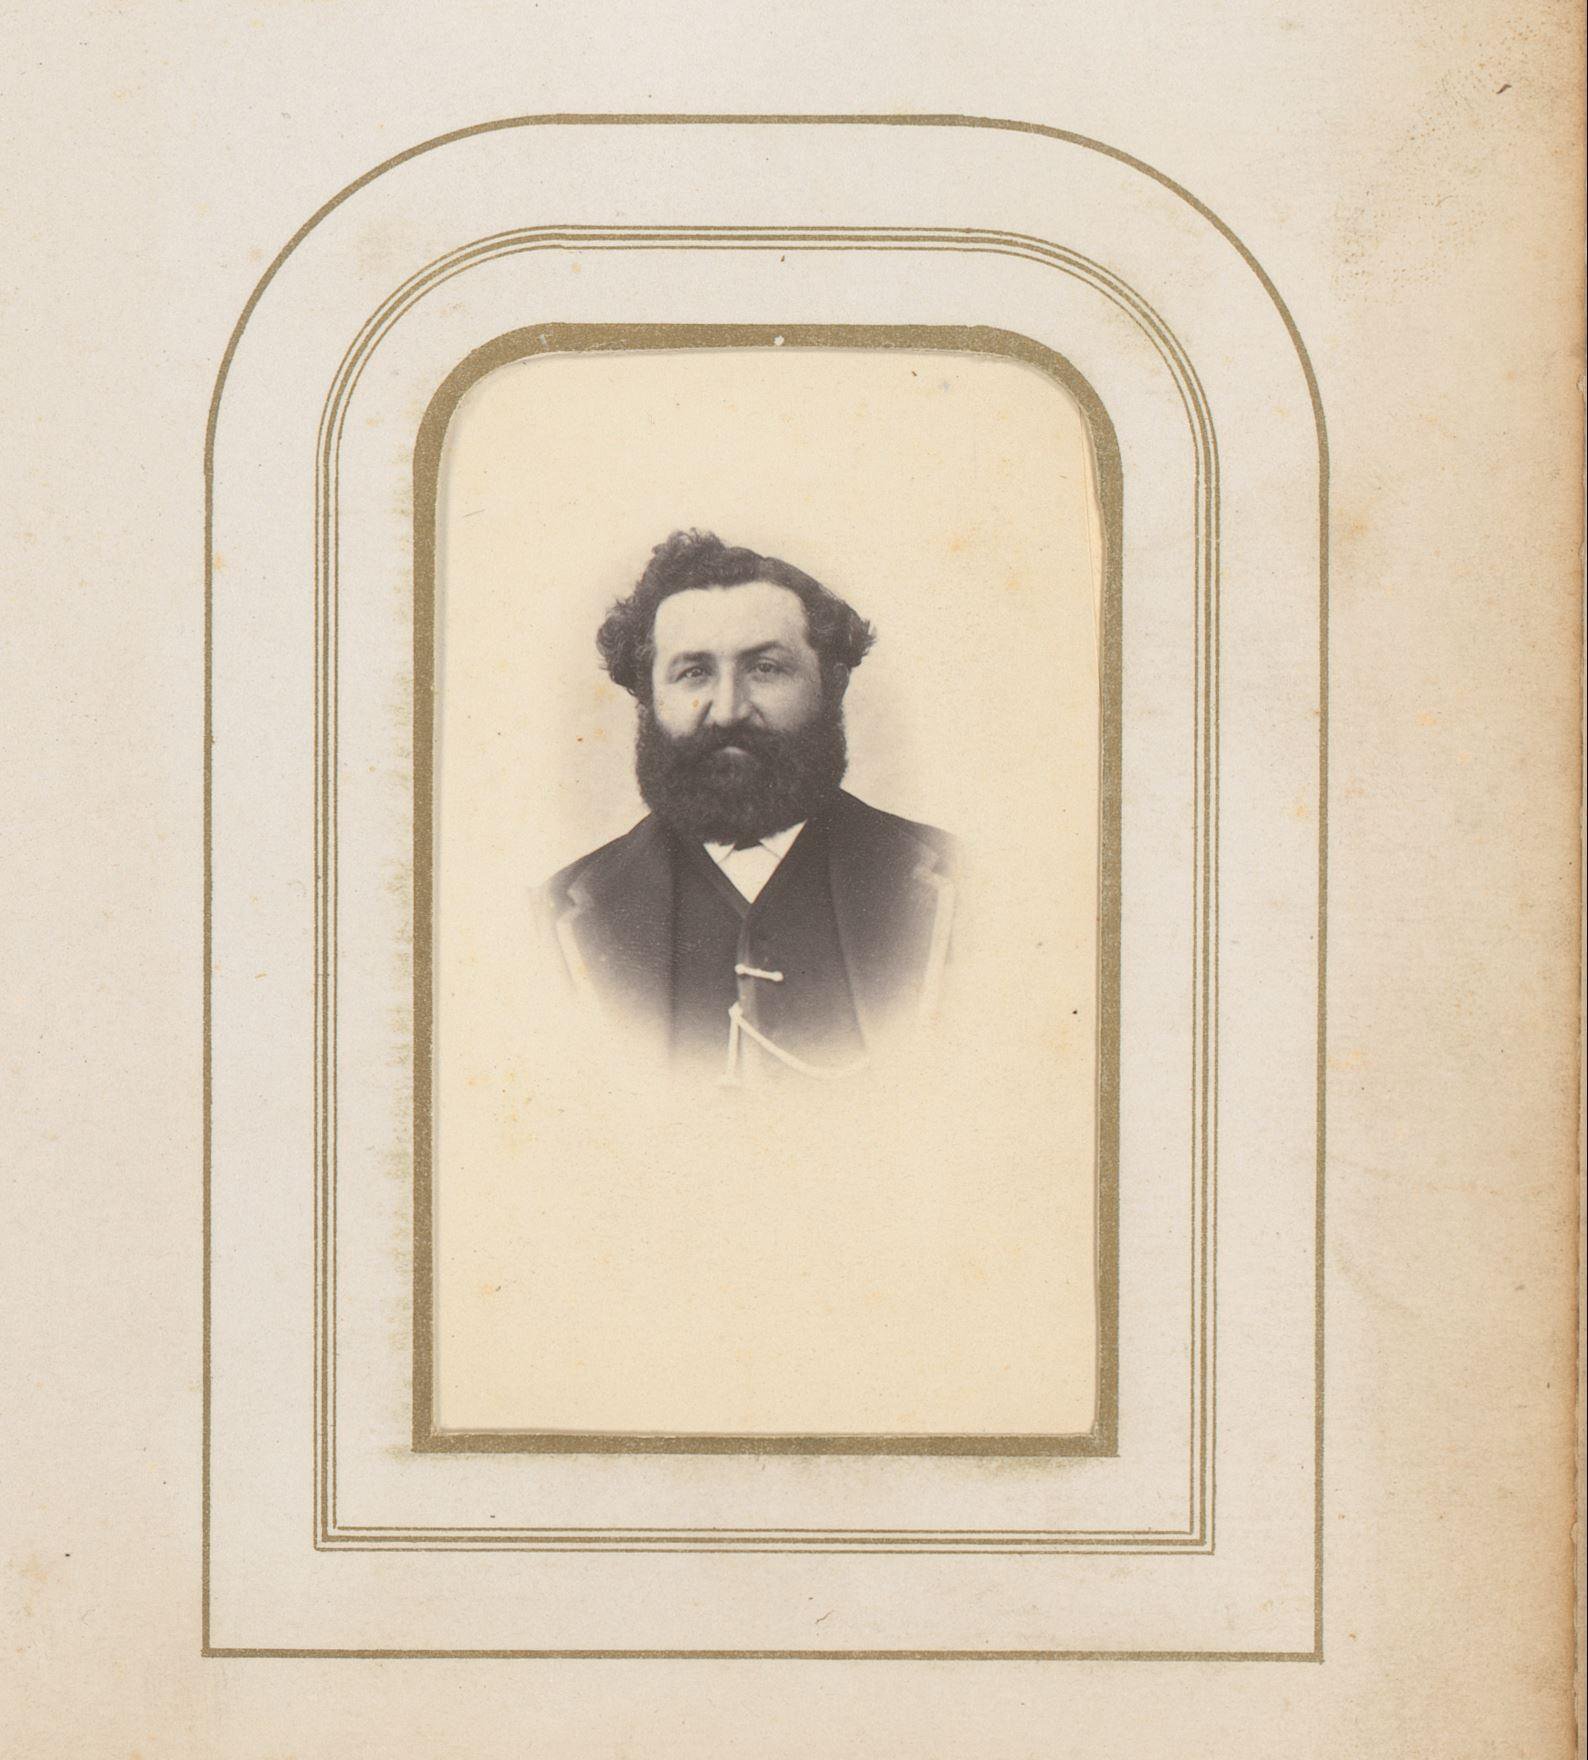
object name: carte de visite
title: Portret van een man met baard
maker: nicolas maroldt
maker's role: fotograaf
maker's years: 1843-1906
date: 1860-1890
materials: cardboard, photographic support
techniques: albumen print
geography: diekirch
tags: historical persons, beard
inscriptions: inscription: ‘Photographisches Atelier/ N. Maroldt/ Diekirch’